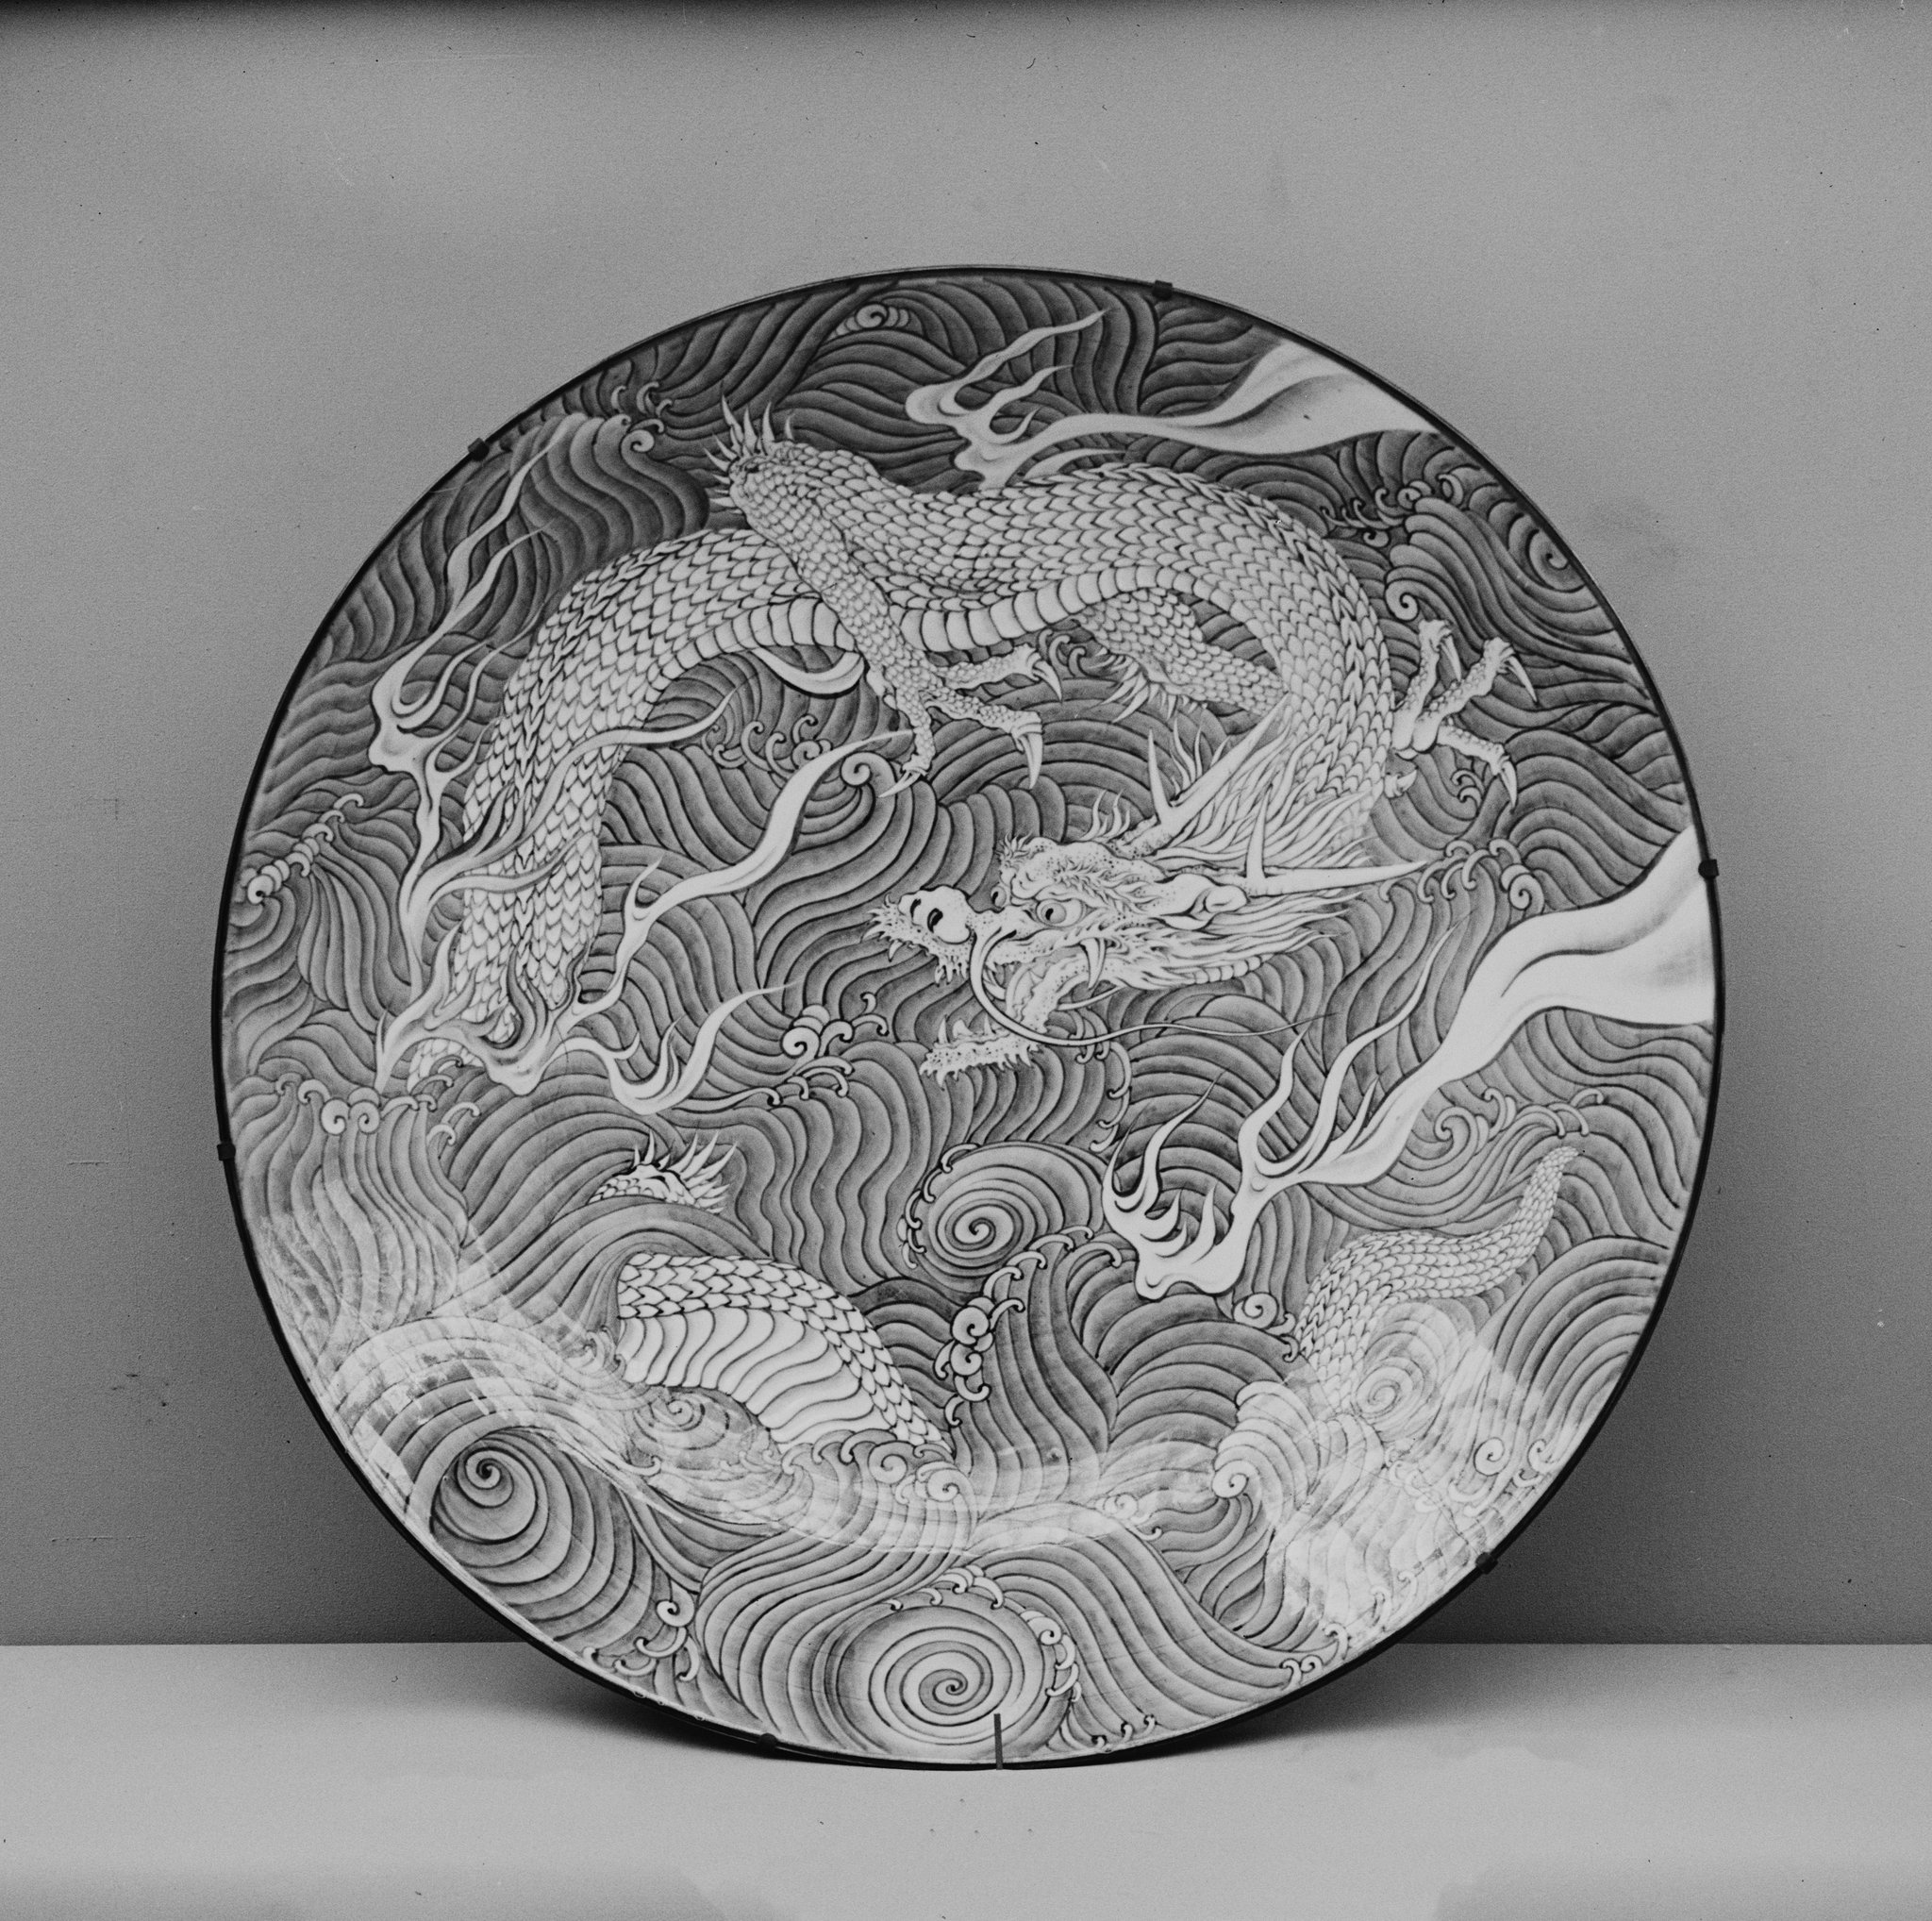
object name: dish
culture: japanese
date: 1801-1900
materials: glaze, porcelain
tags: dragons